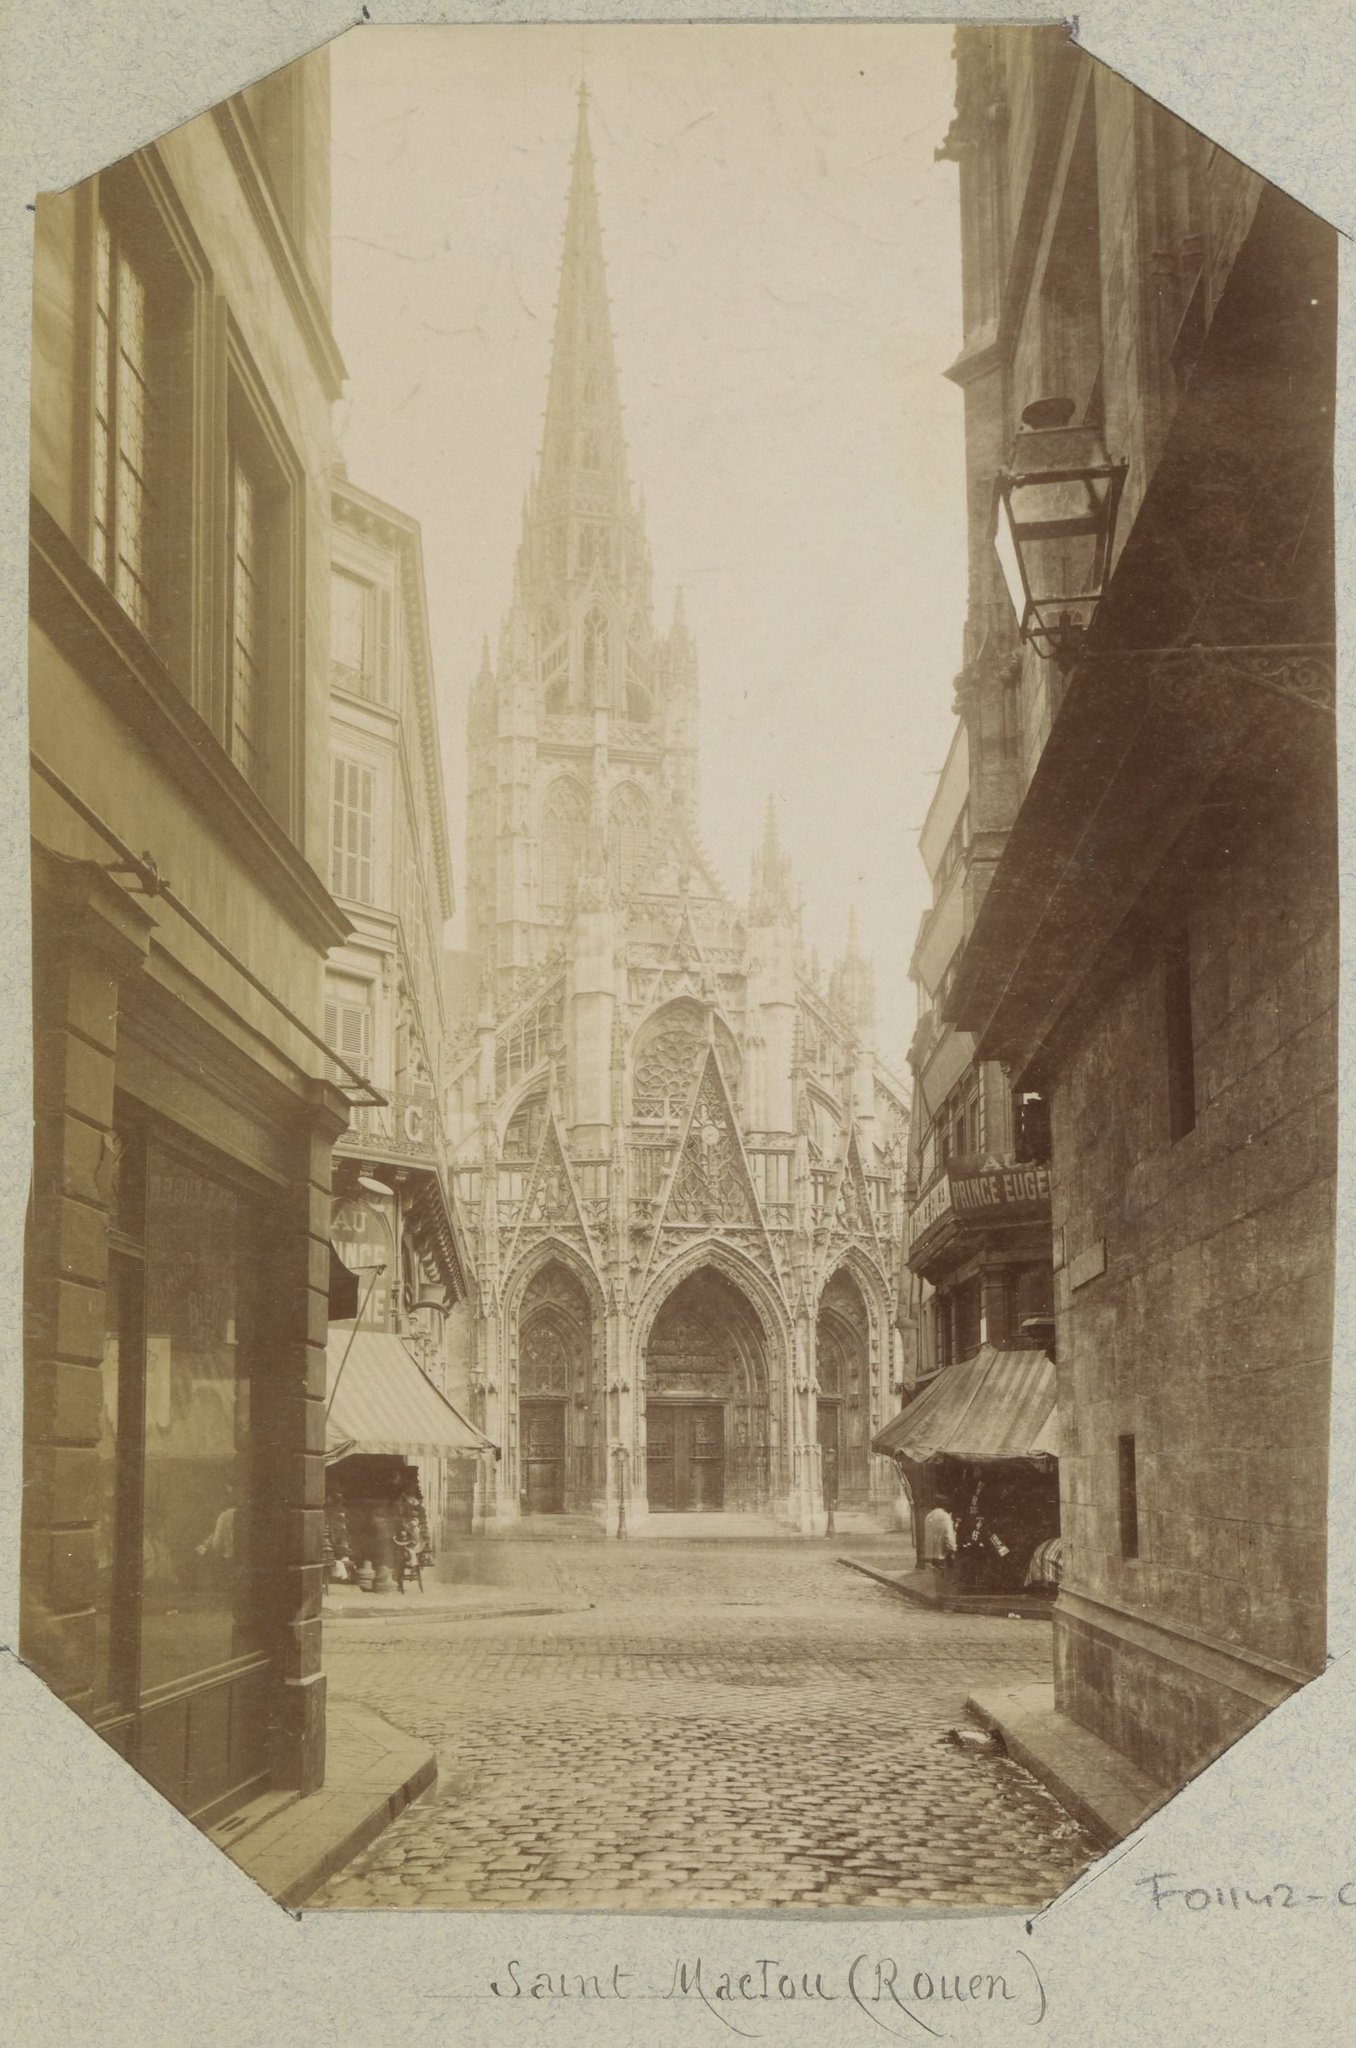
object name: album leaf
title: Kerk Saint-Maclou gezien door een straat in Rouen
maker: Anonymous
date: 1880-1900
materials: paper, photographic support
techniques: albumen print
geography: rouen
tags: church (exterior), parts of church exterior and annexes: tower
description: Onderdeel van Album van een Franse amateur met foto's van Frankrijk, Algerije, Palmyra, de Wereldtentoonstelling van 1900 en van bekende Fransen.